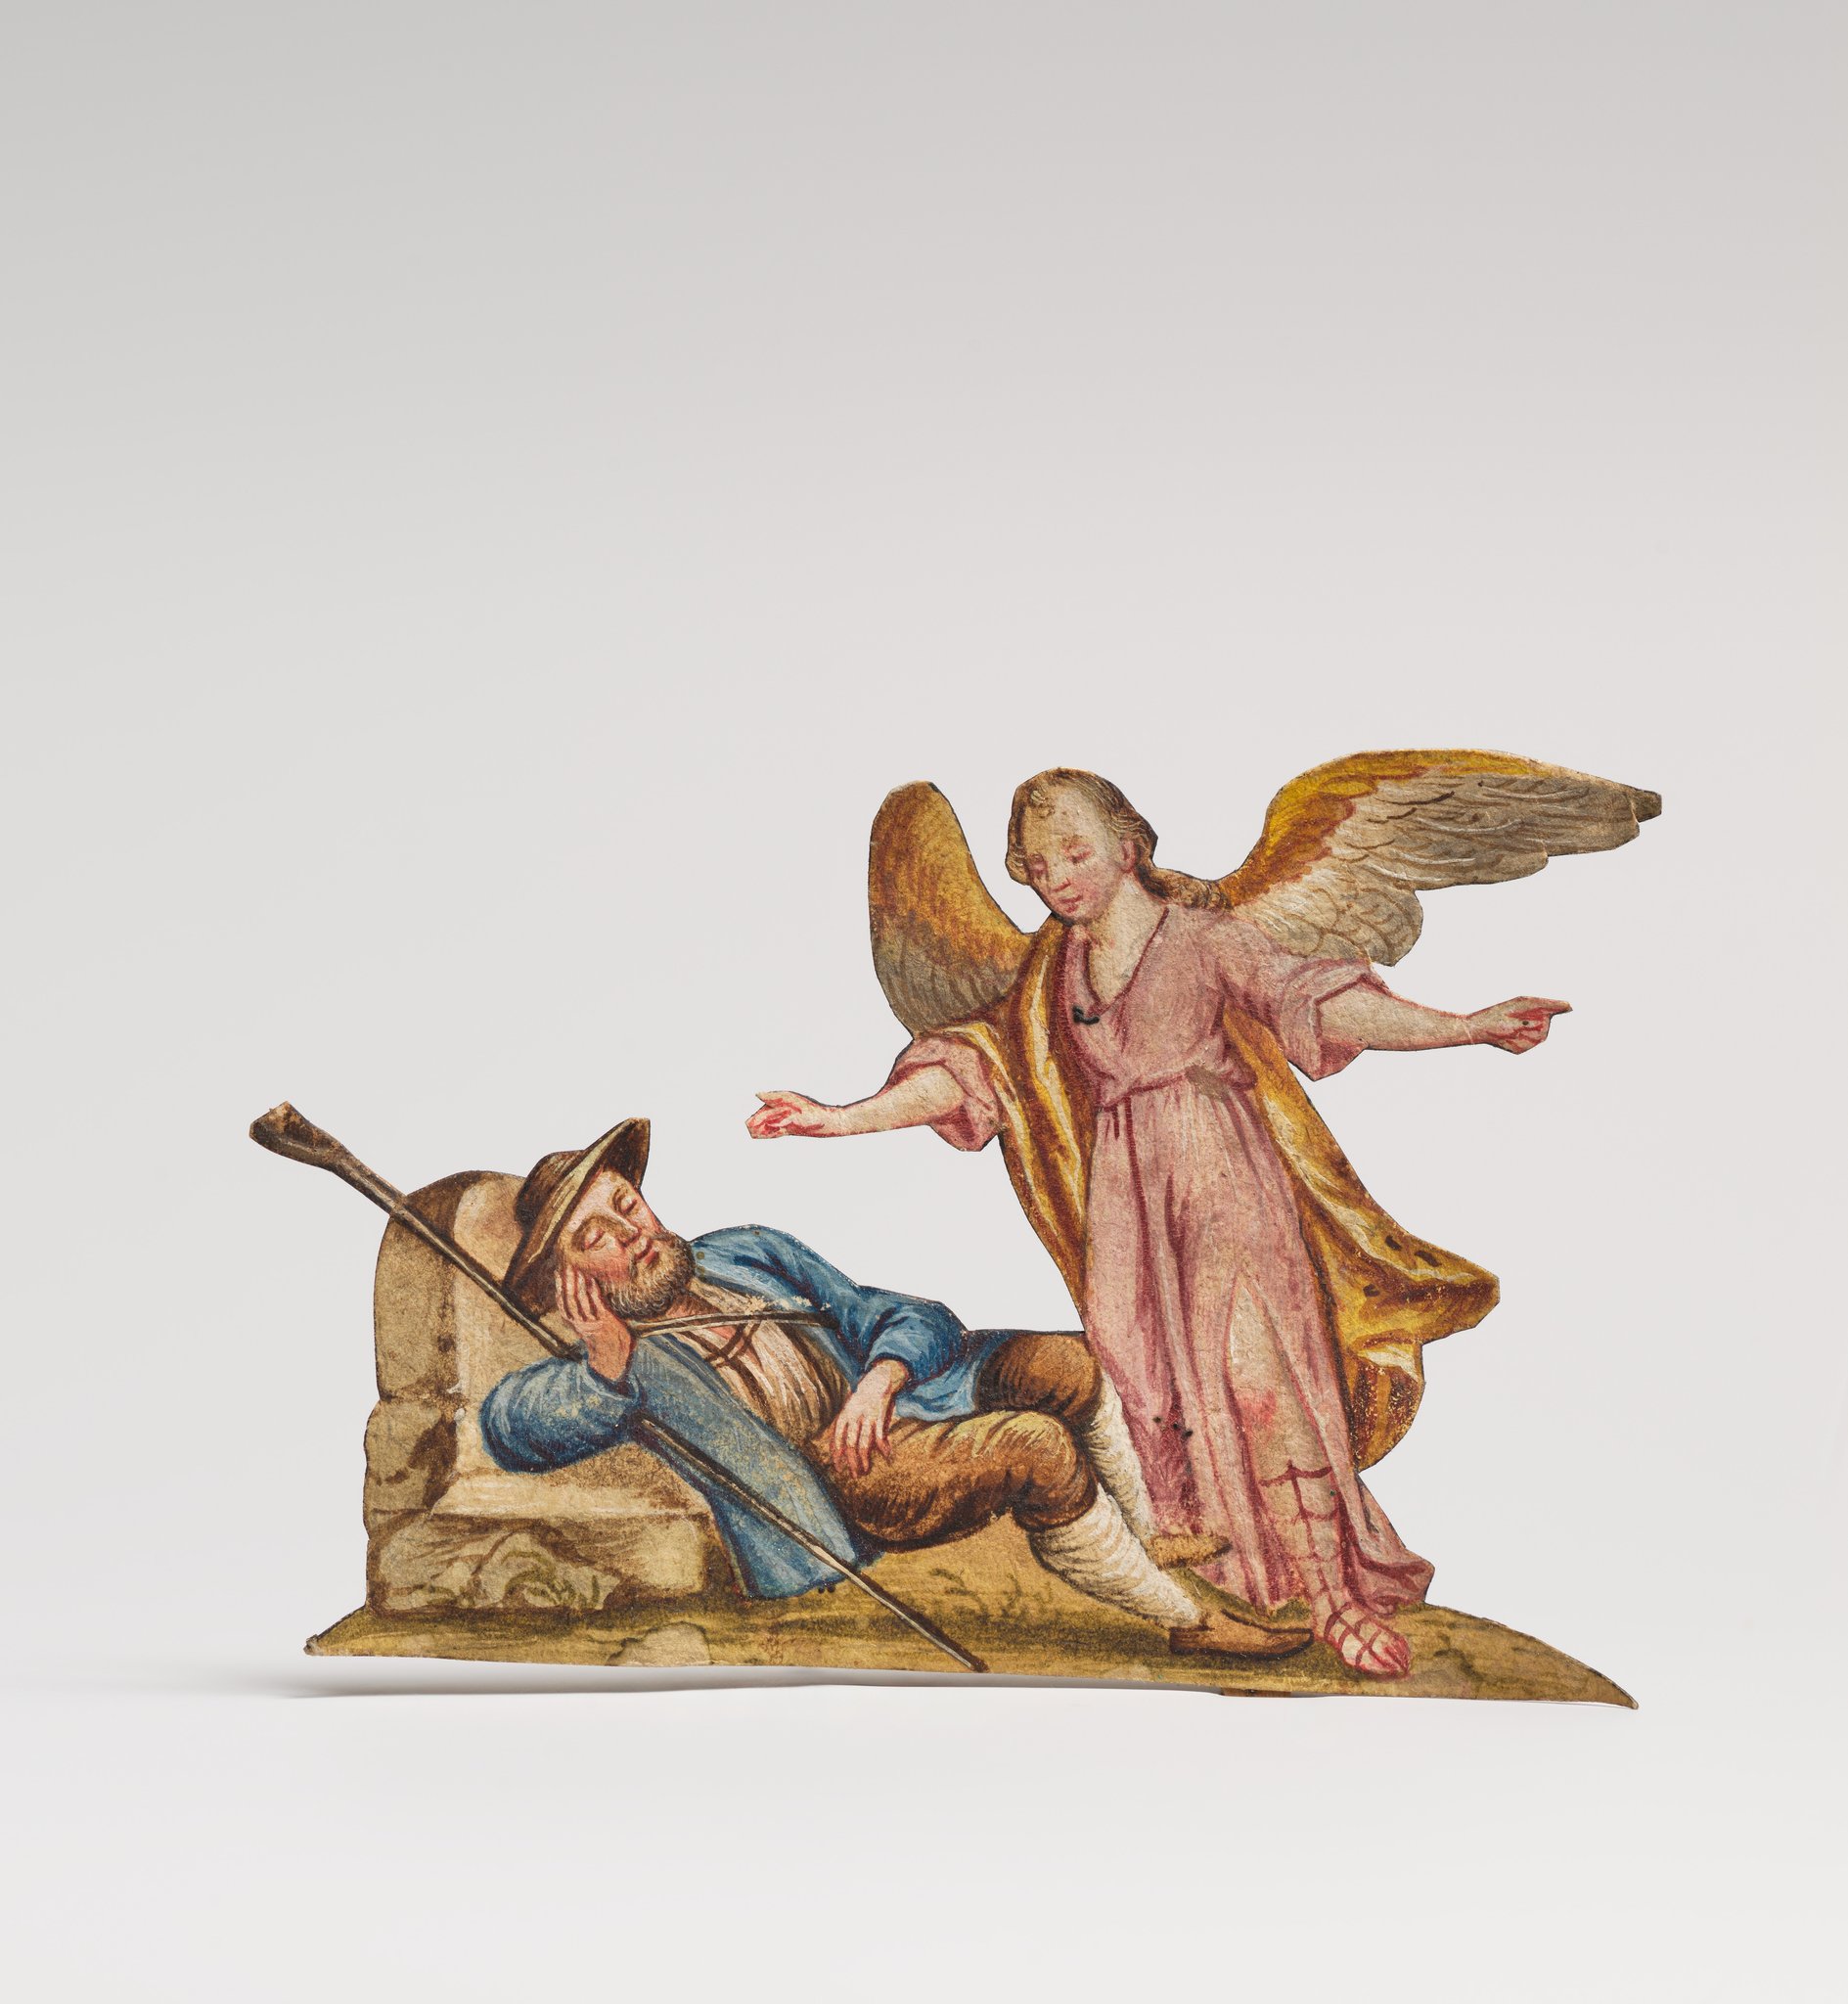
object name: figure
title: Angel Appearing to Sleeping Shepherd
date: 1701-1800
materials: gouache, paper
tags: sleeping,angels,shepherds